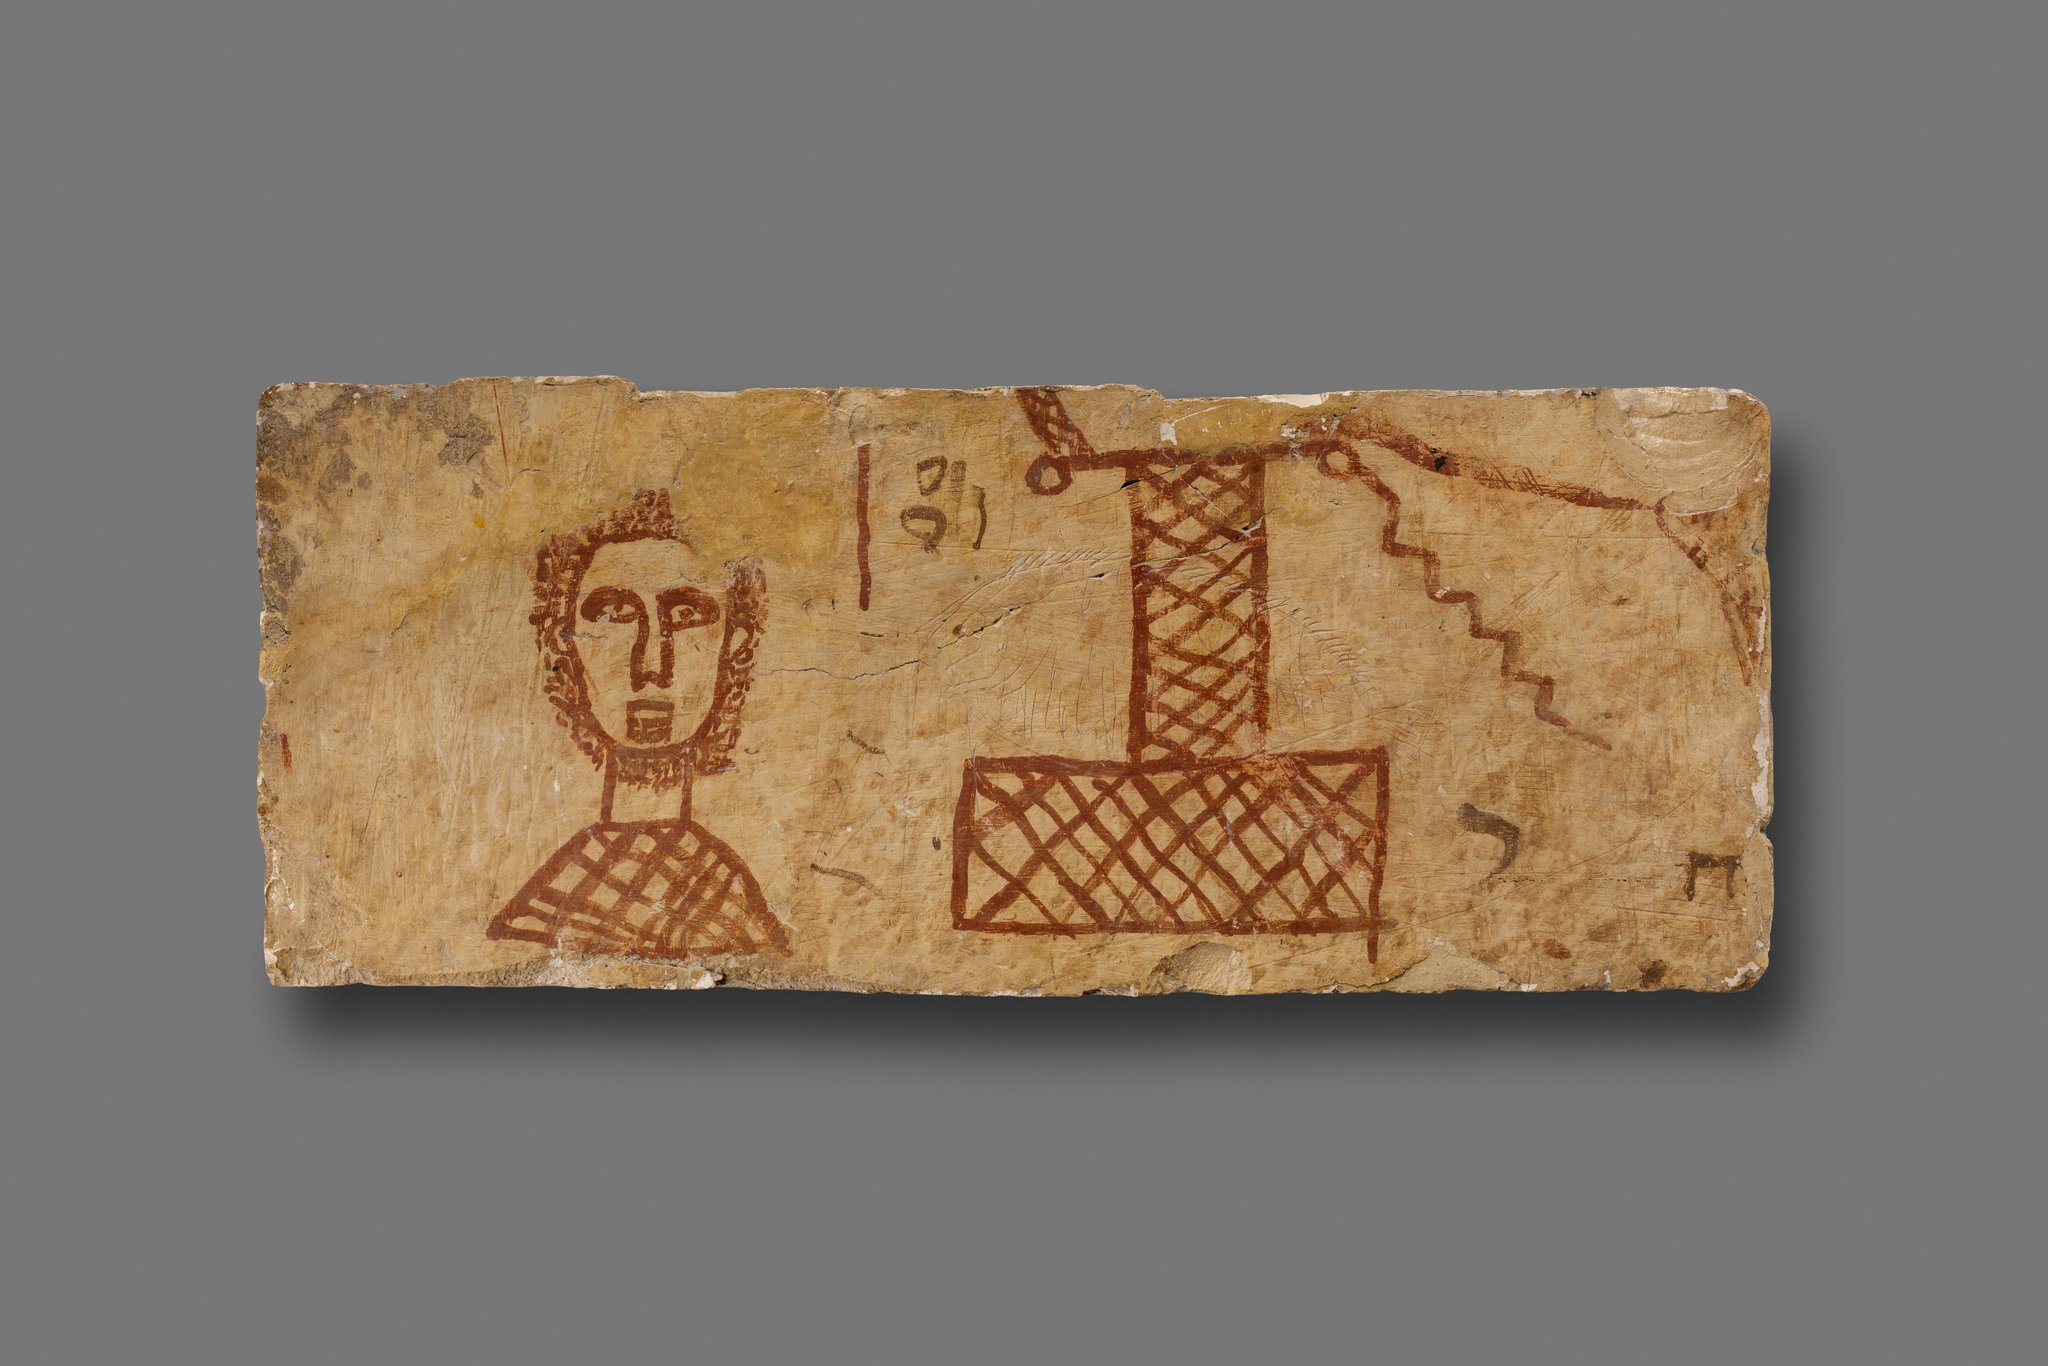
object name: relief, tomb of nespekashuty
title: Drawing of a Coptic Saint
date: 501-700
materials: limestone, paint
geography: egypt